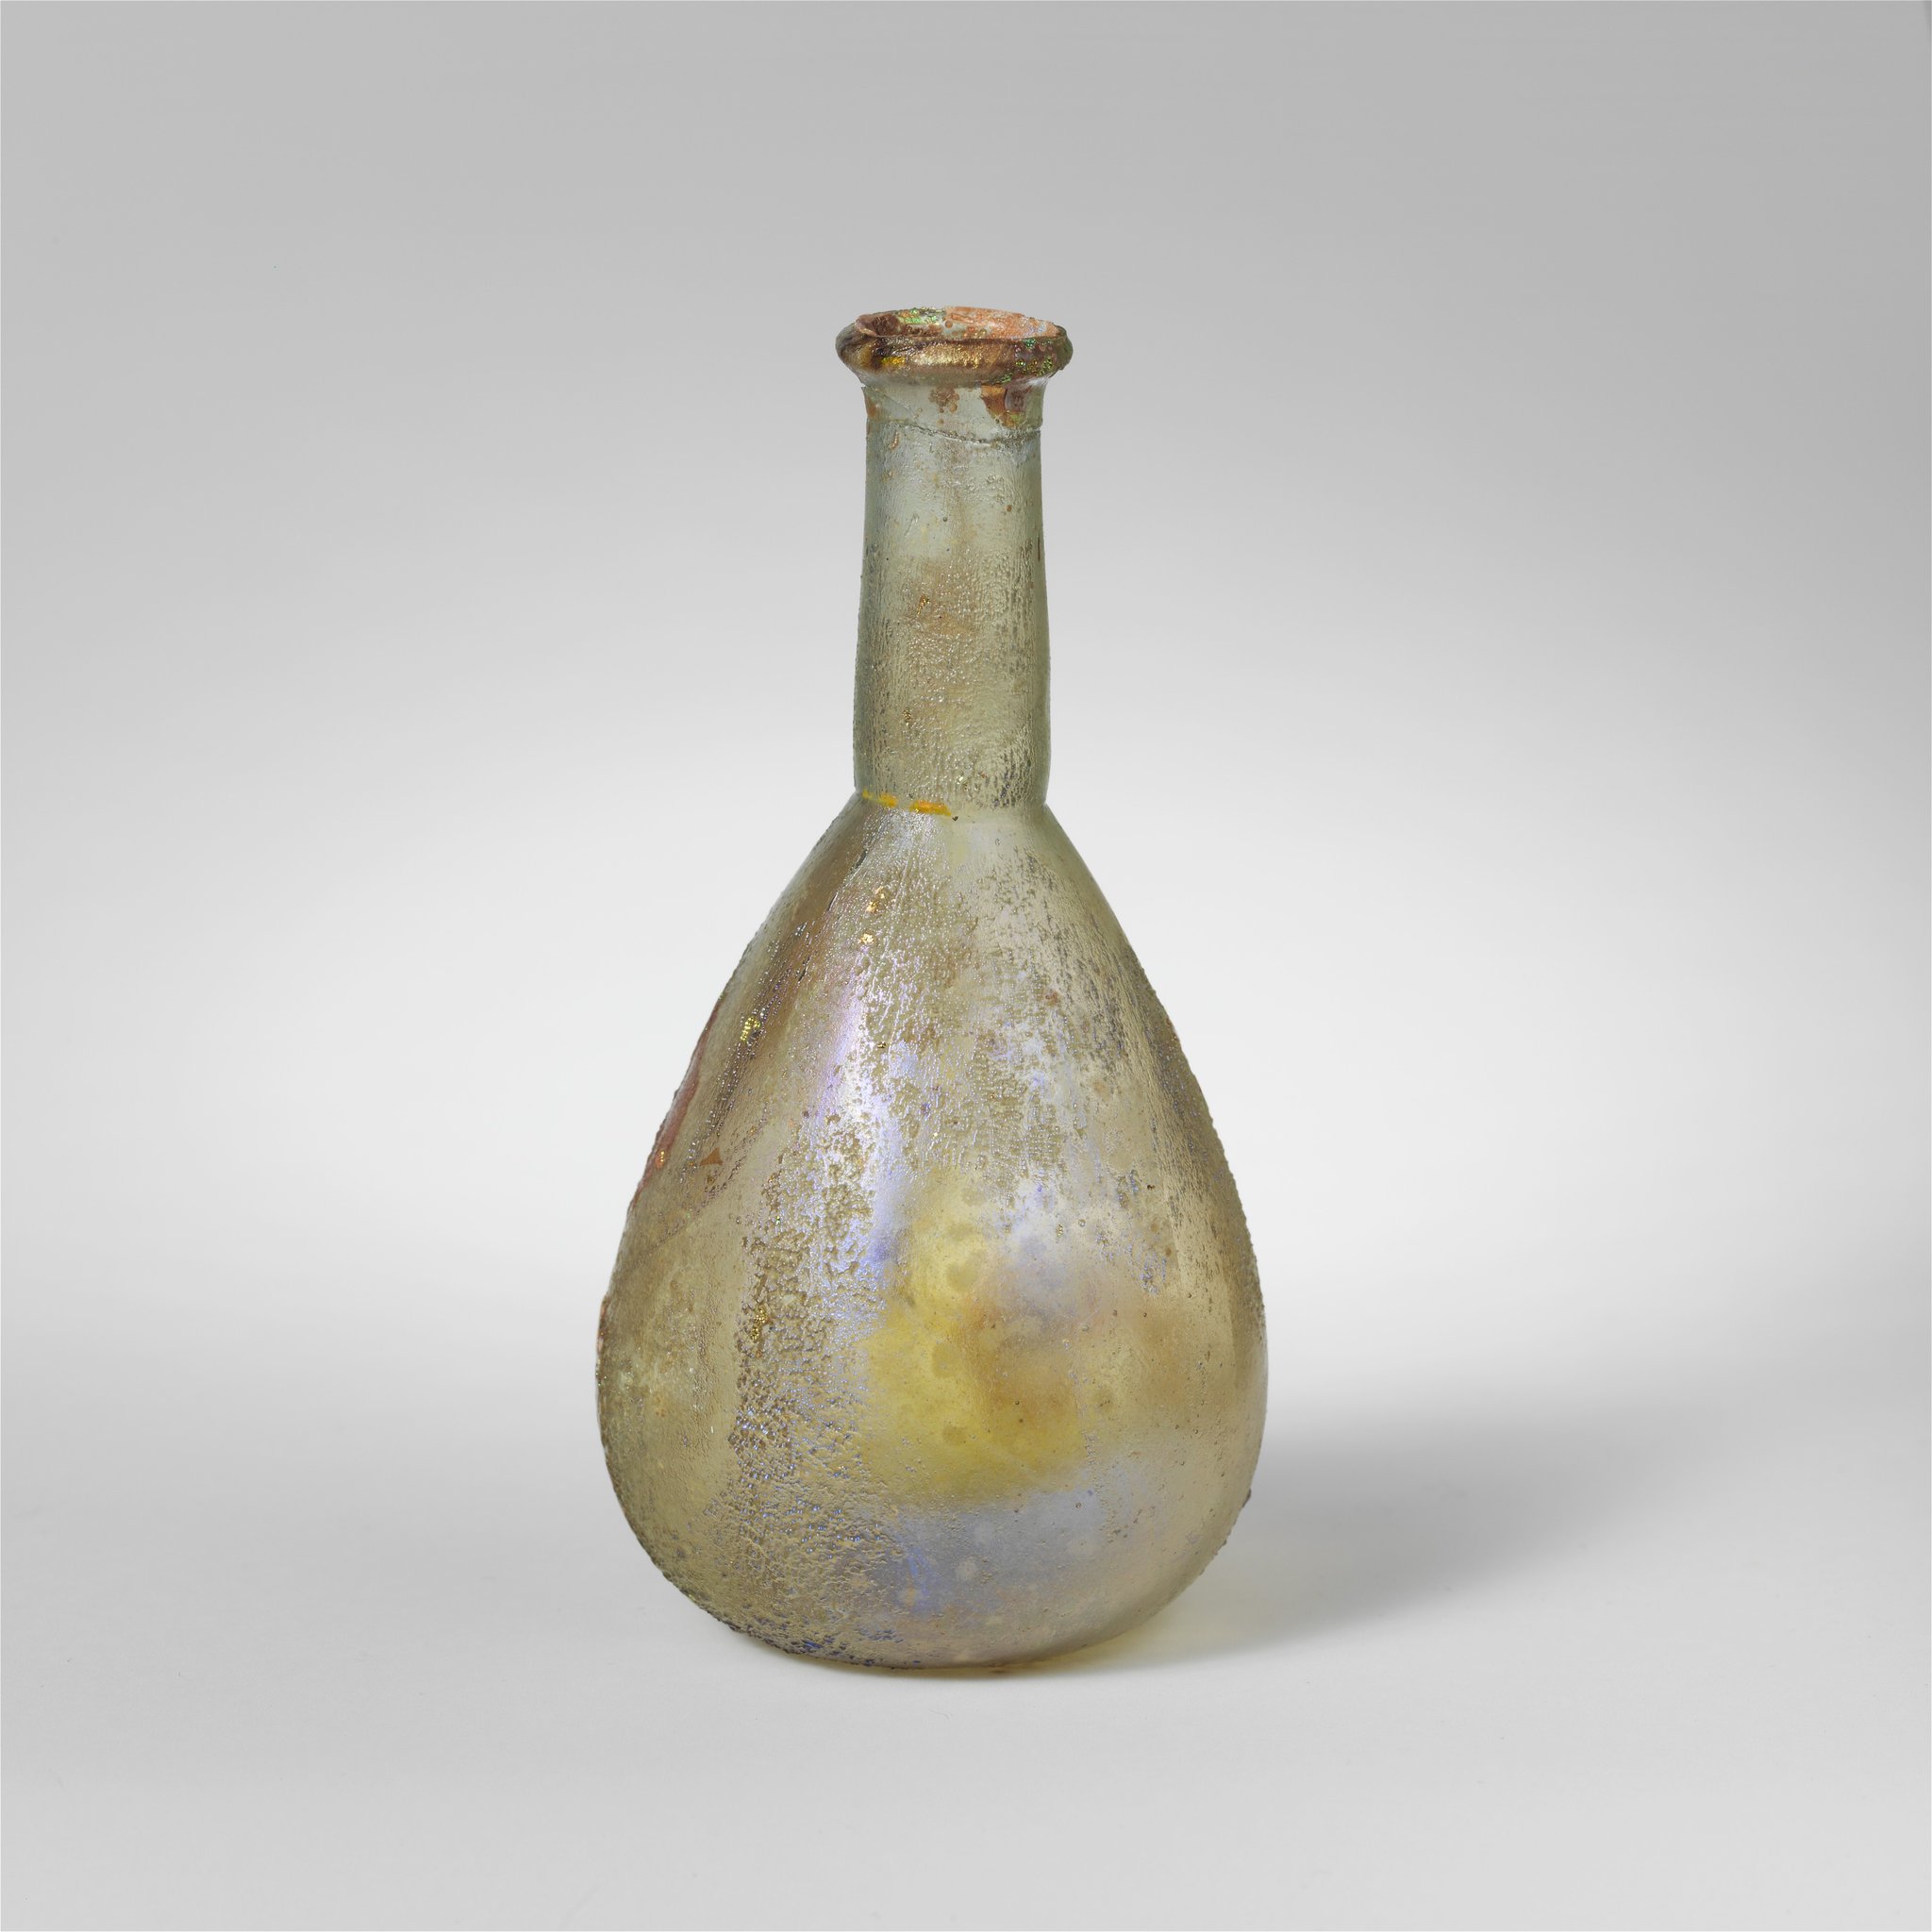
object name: perfume bottle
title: Glass perfume bottle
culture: roman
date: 1-100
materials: glass